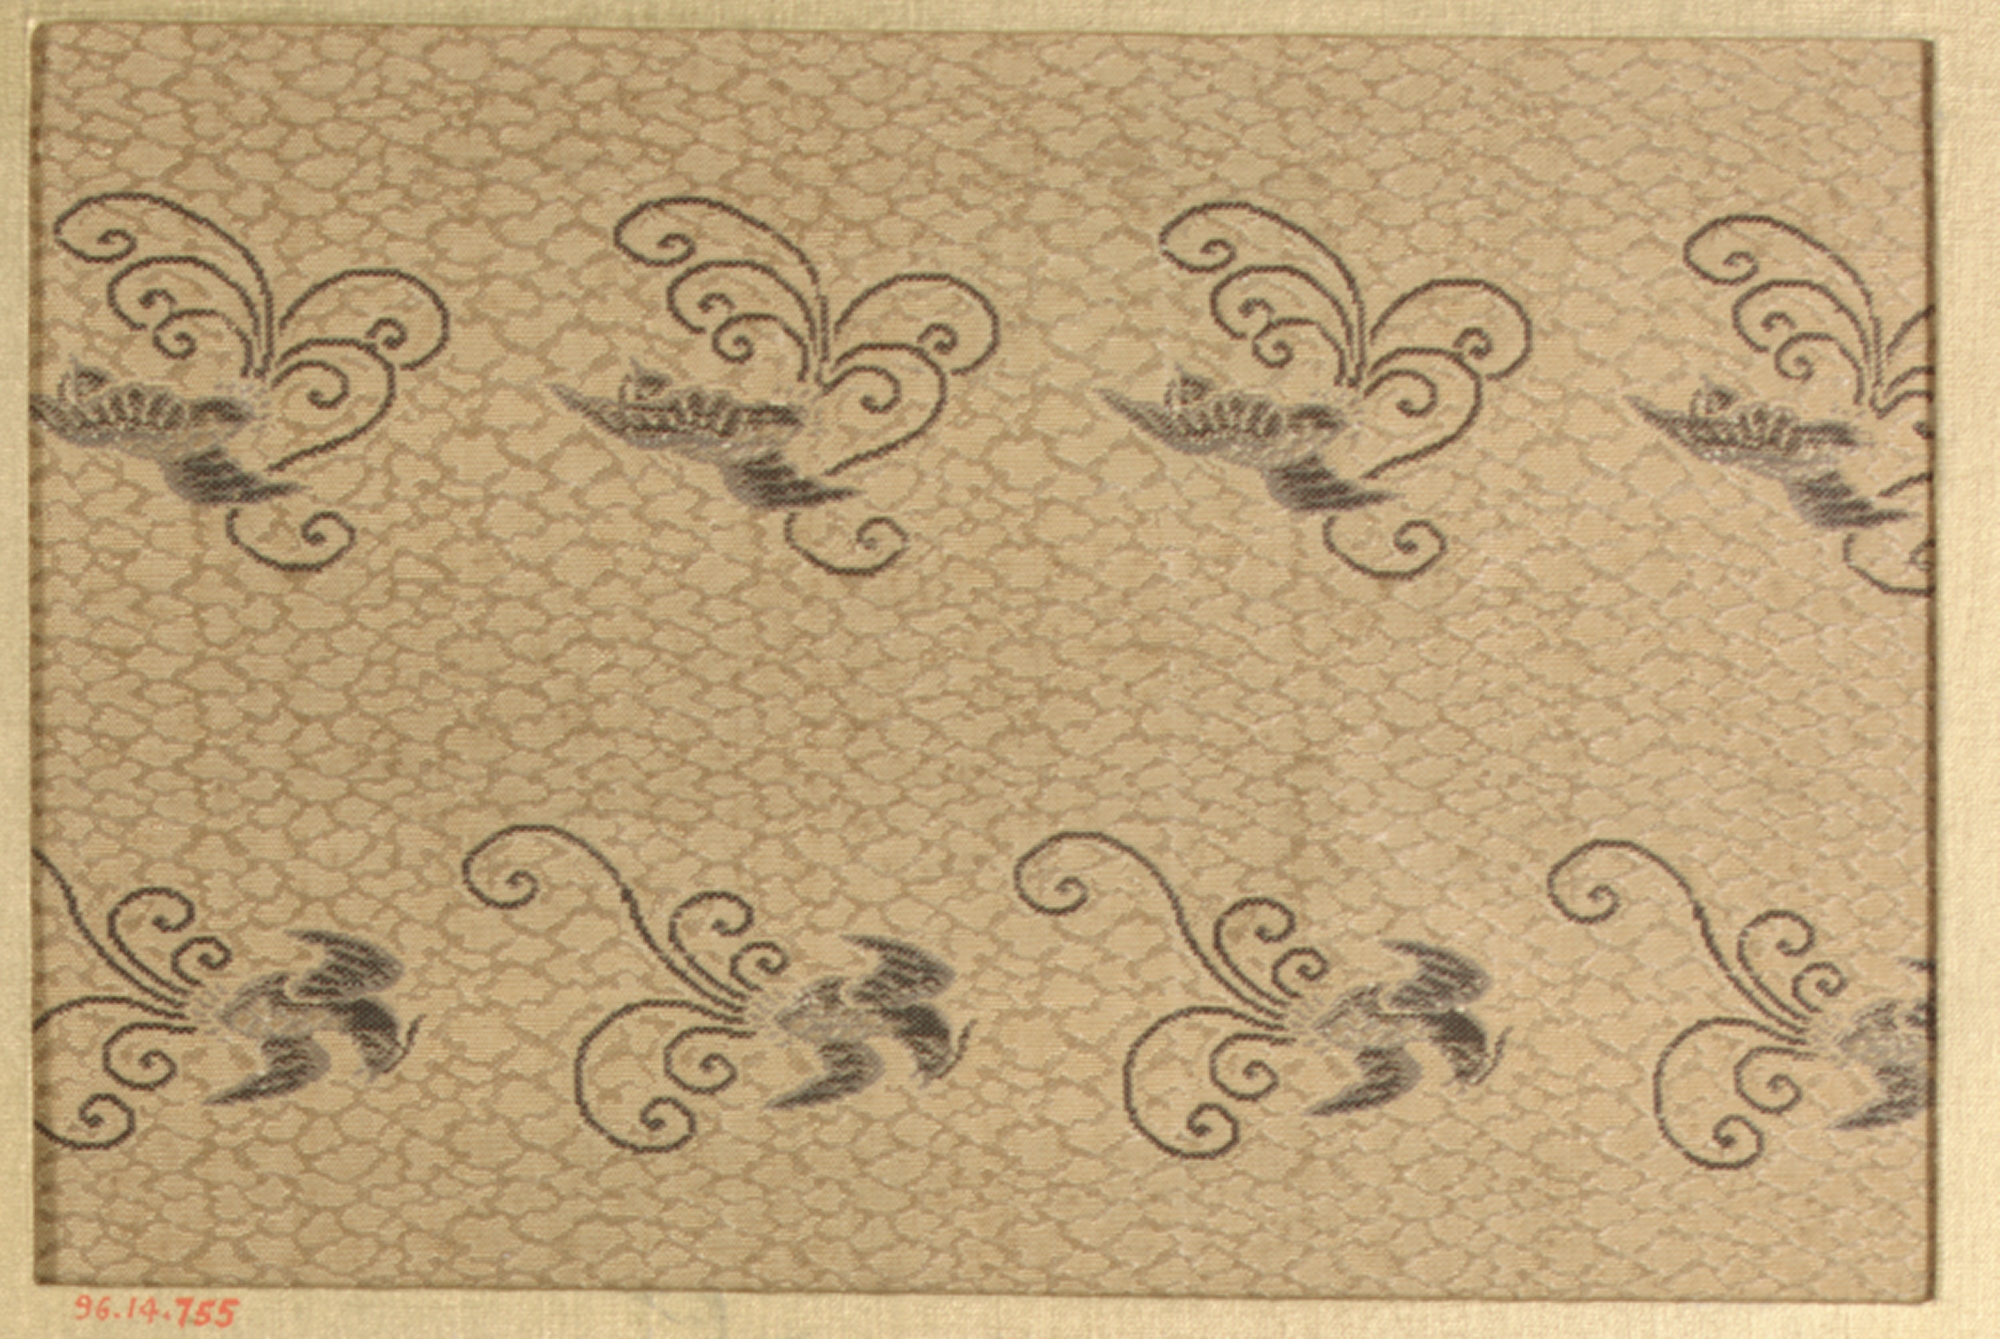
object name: piece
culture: japanese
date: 1701-1900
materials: silk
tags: birds